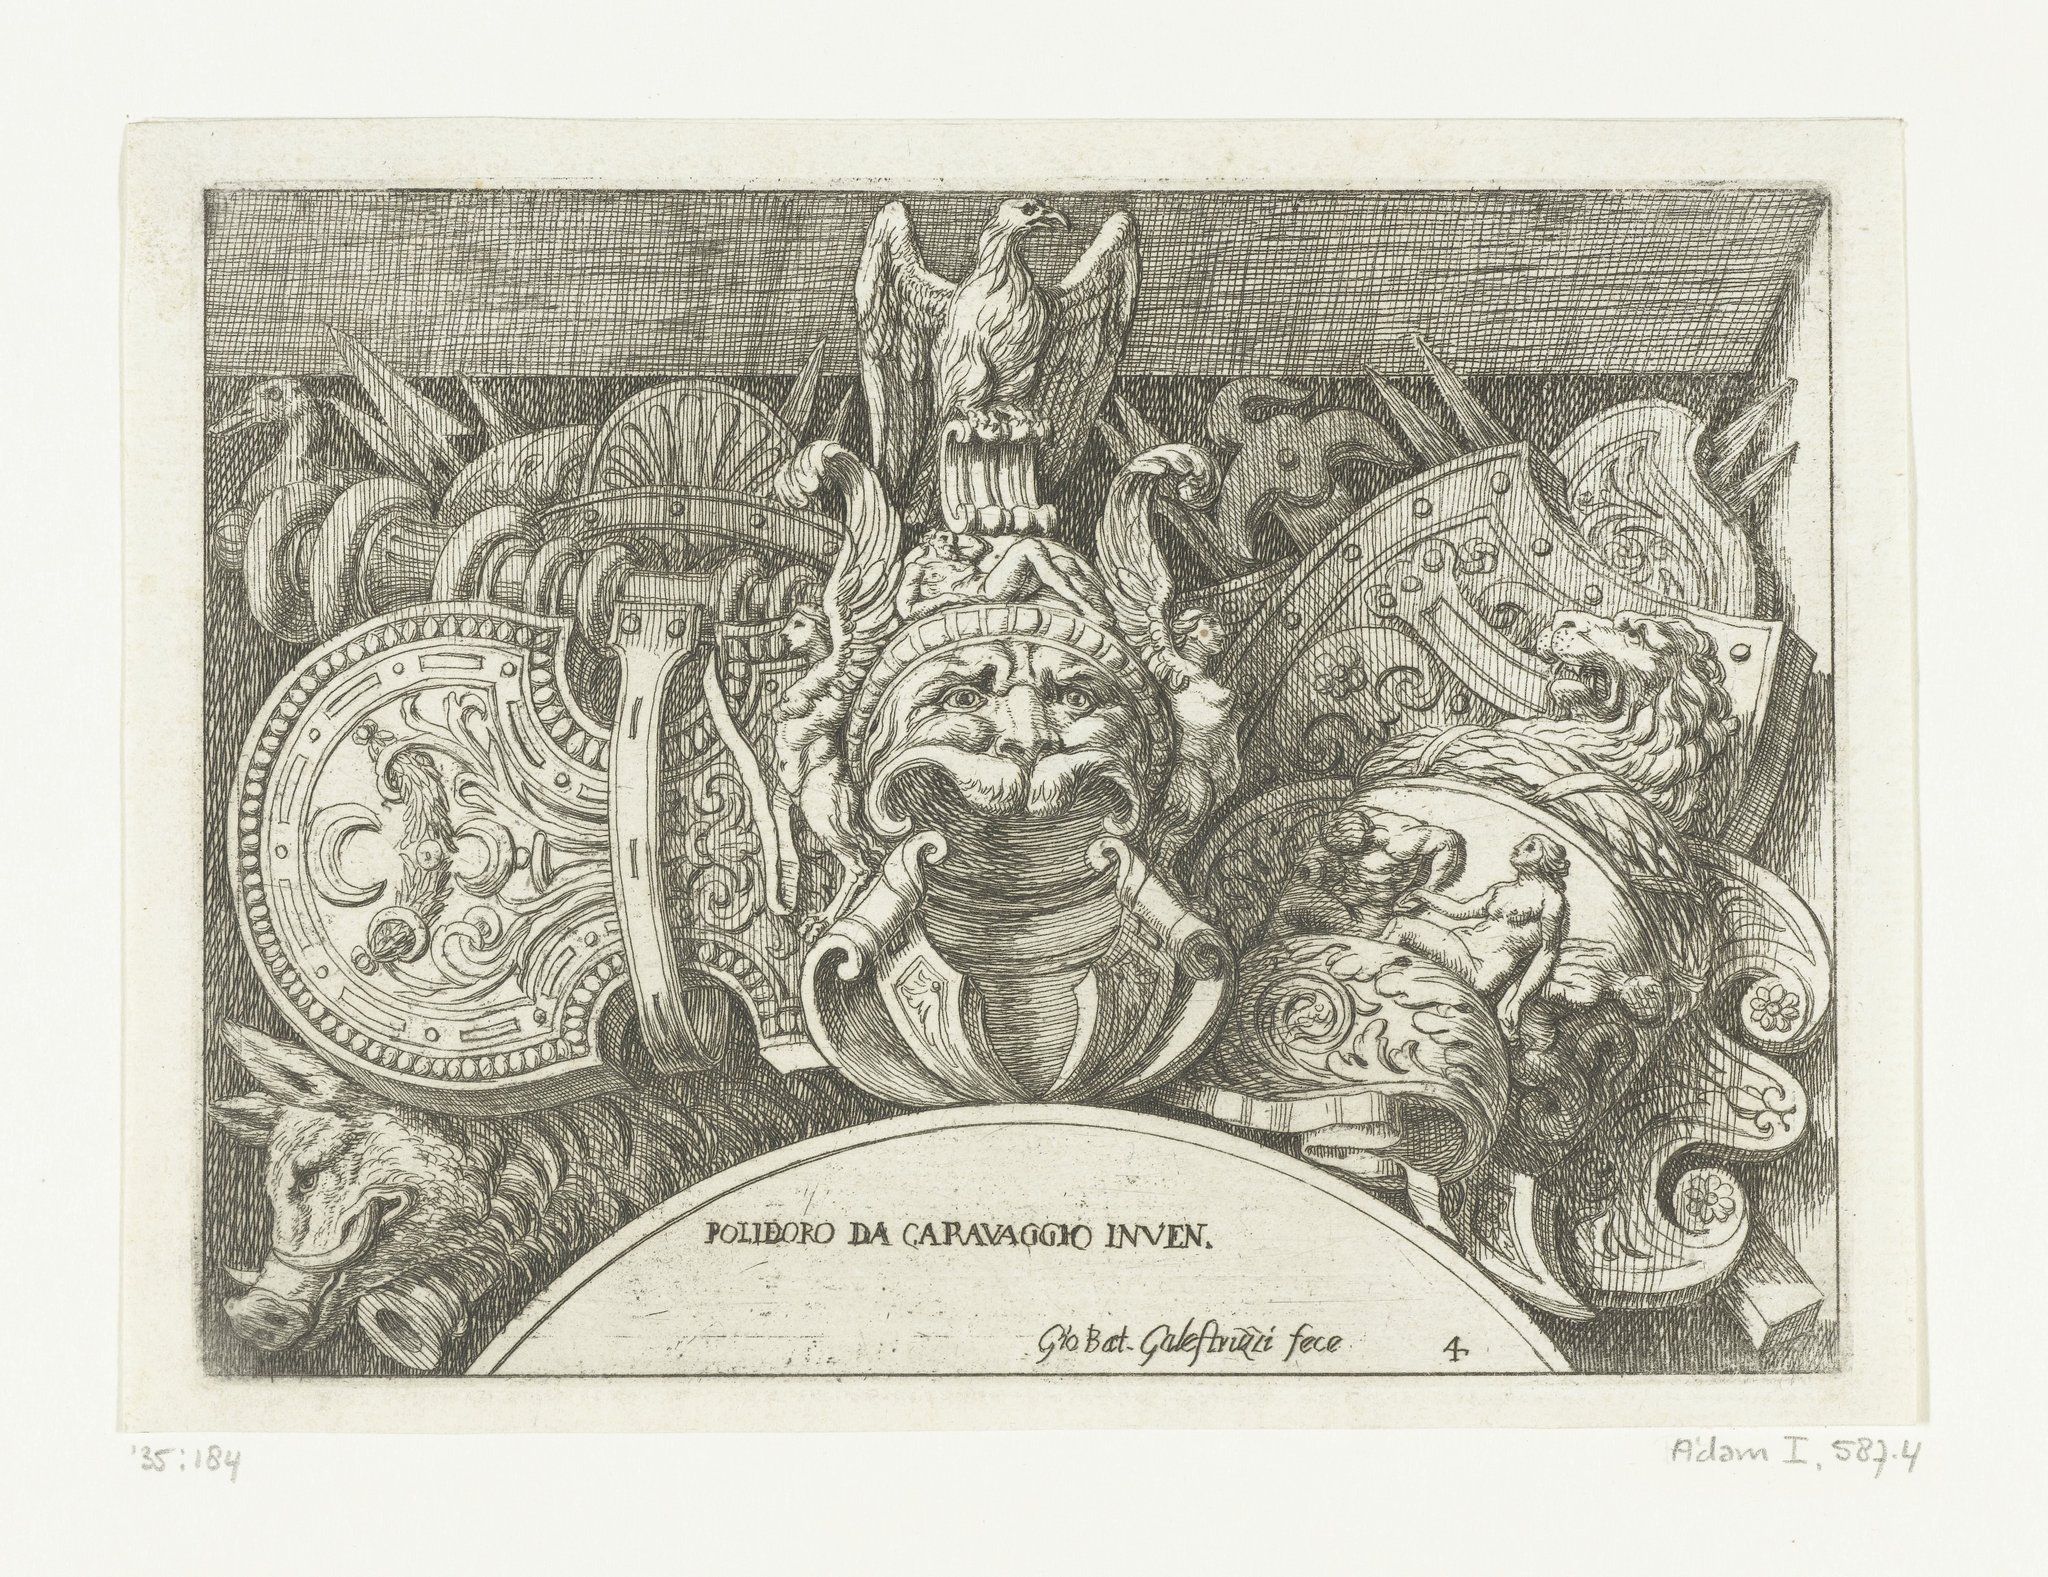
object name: ornament print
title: Opere di Polidoro da Caravaggi (...)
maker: giovanni battista galestruzzi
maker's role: painter, print maker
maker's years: 1618-1661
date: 1658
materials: paper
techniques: etching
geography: italy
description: Bovenop de helm zit een adelaar. Wapentrofee, liggend in een vierkante nis. Midden onder bevindt zich een halfrond wit vlak met inscriptie.